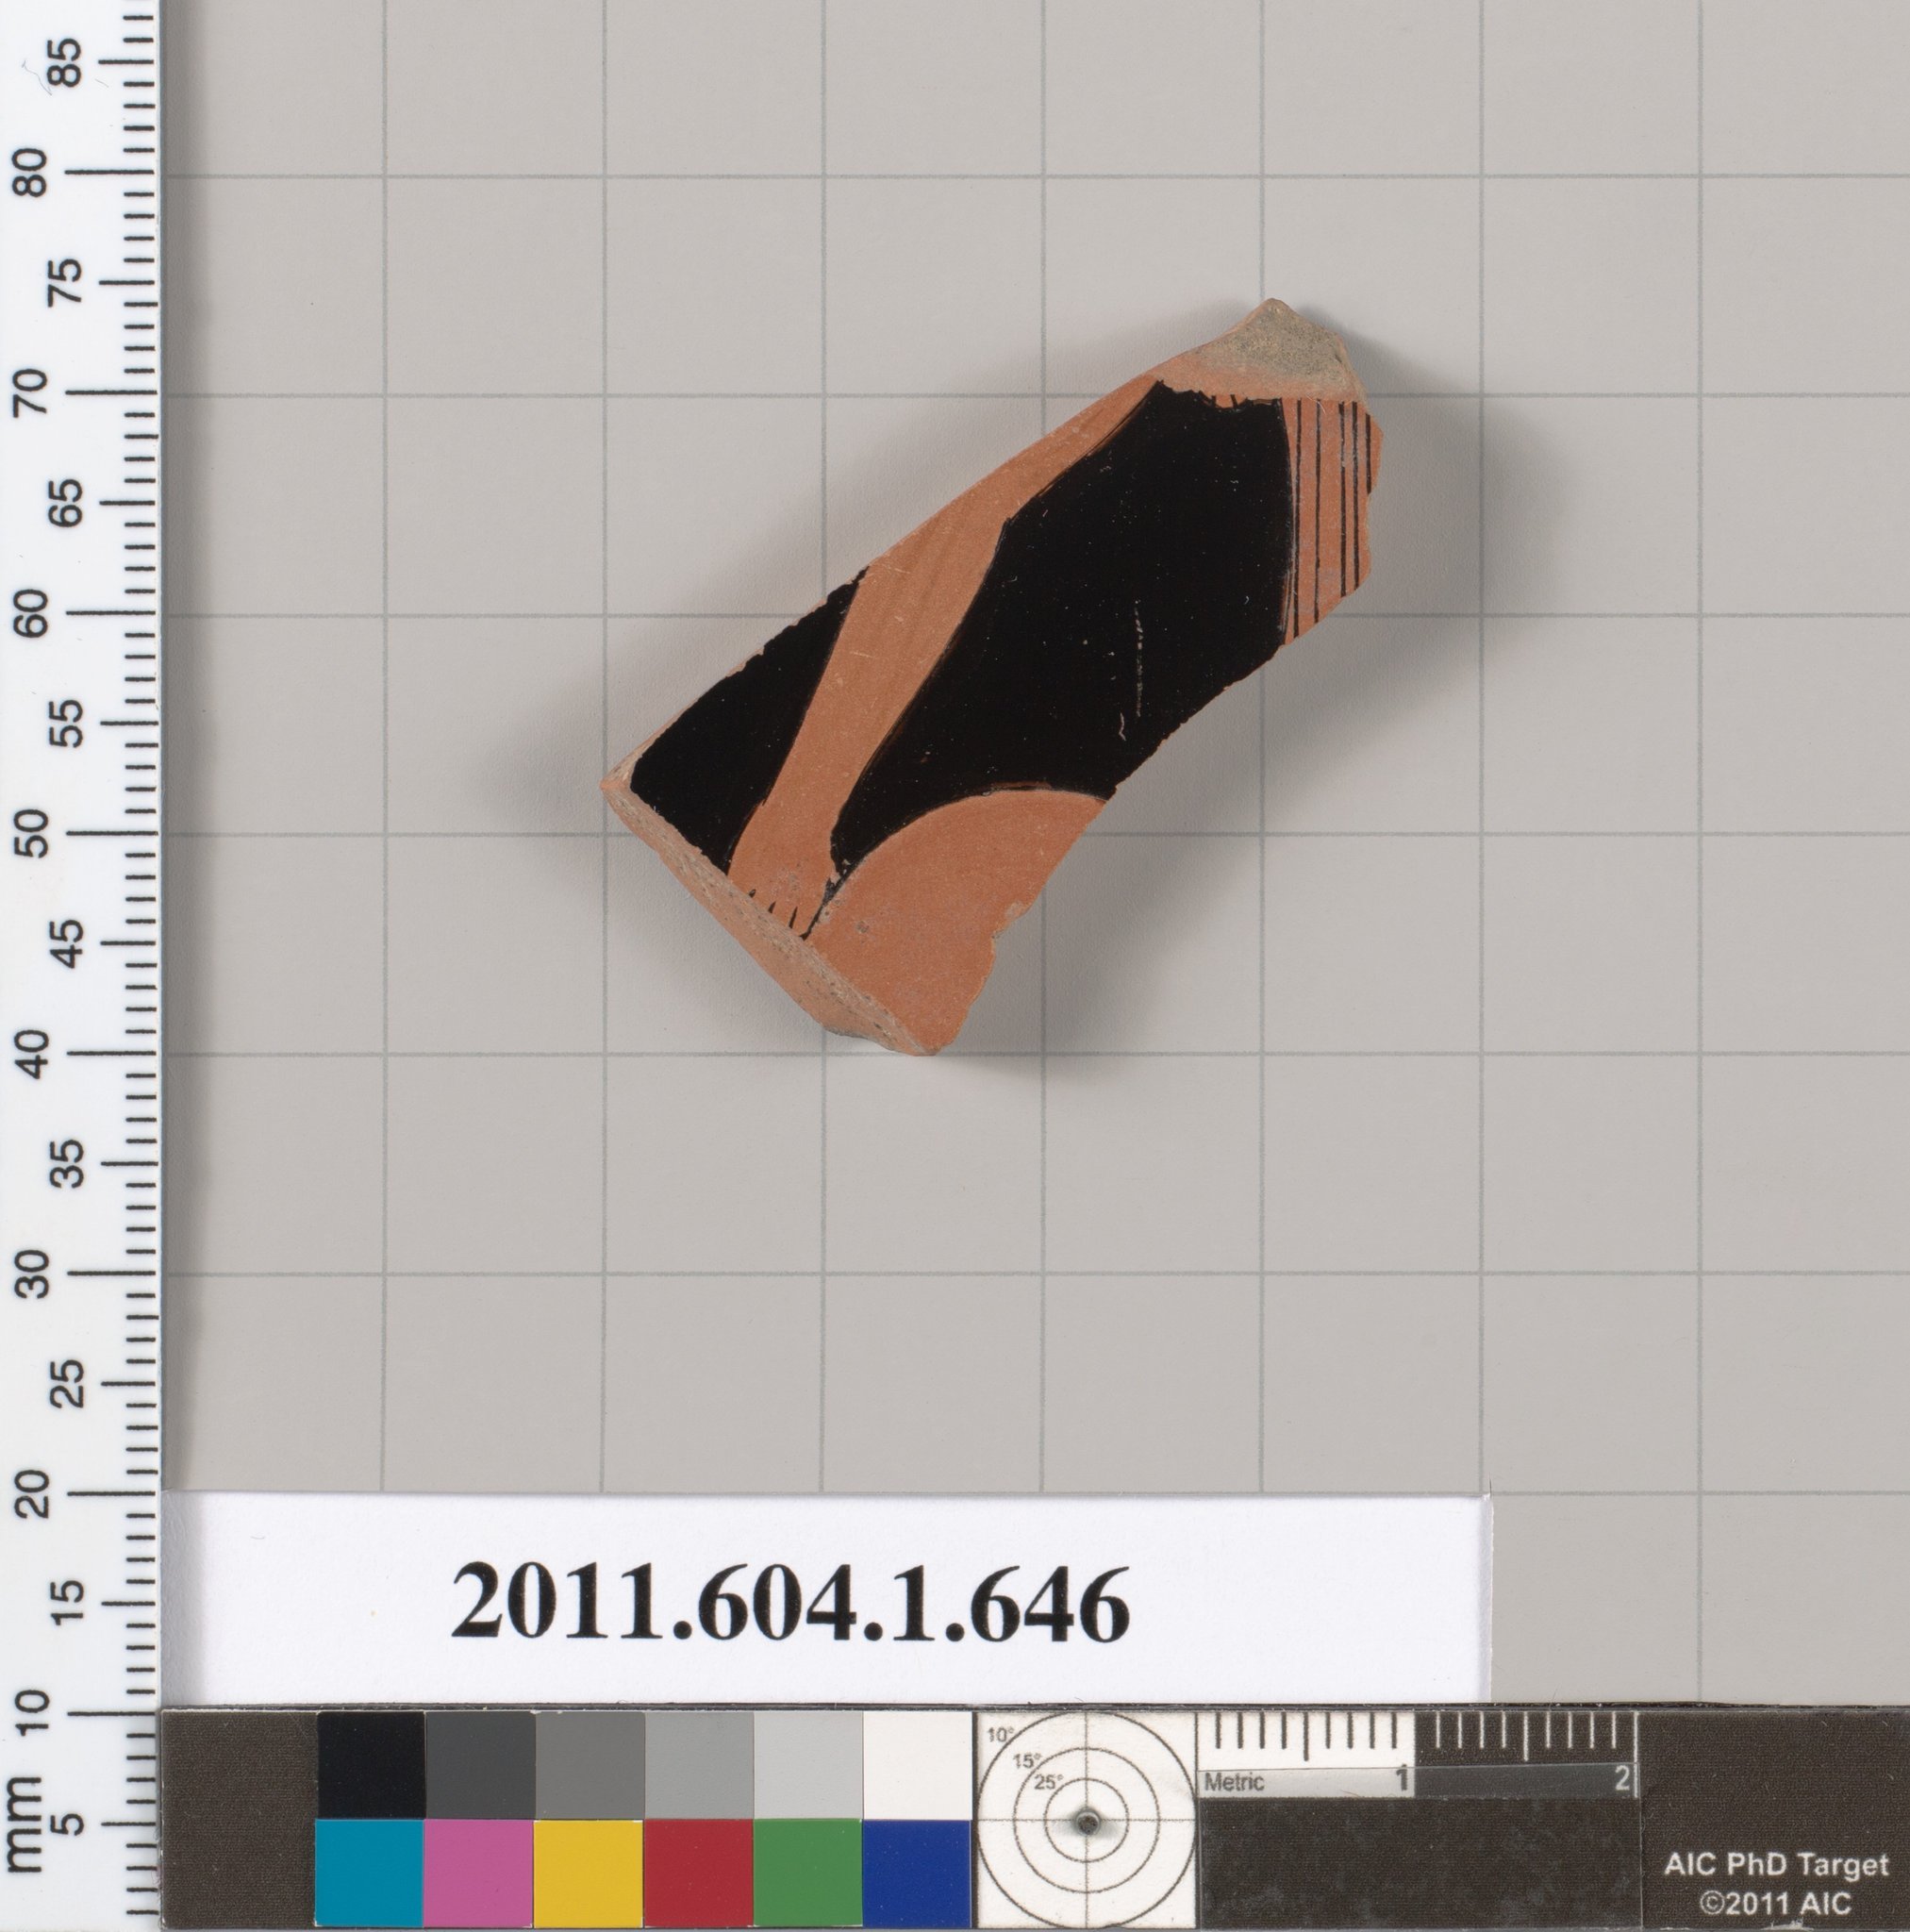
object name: kylix fragment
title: Terracotta fragment of a kylix (drinking cup)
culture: greek, attic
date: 475-451 BCE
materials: terracotta